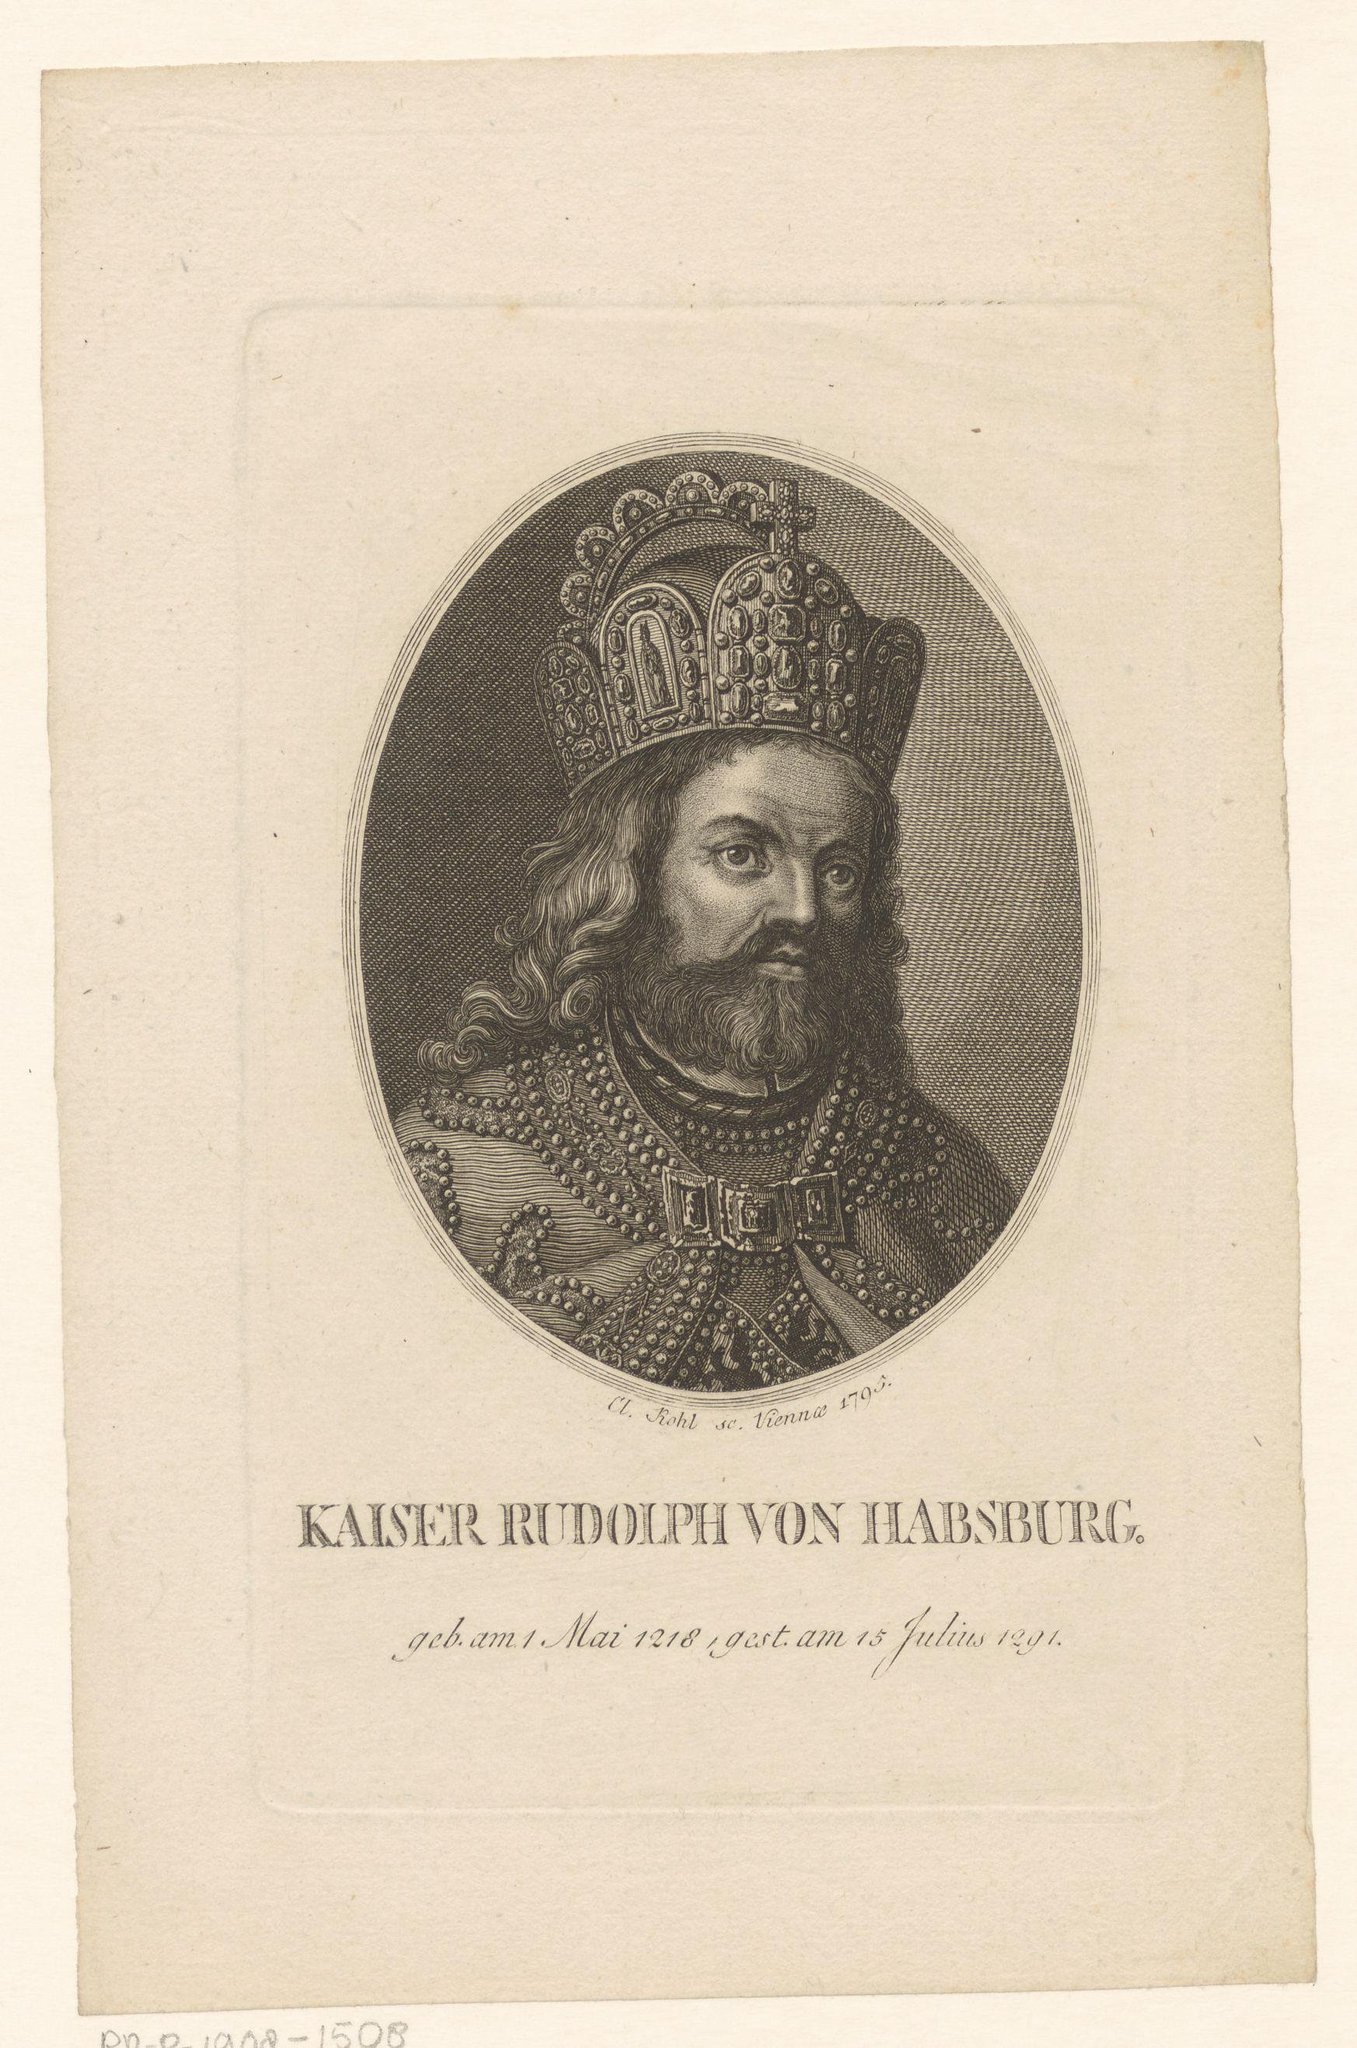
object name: print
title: Portret van Rudolf I van Habsburg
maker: clemens kohl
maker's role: draughtsman, print maker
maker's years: 1754-1807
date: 1795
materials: paper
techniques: engraving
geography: vienna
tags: commander-in-chief, general, marshal, historical persons, king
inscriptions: collector's mark: Lugt 2228